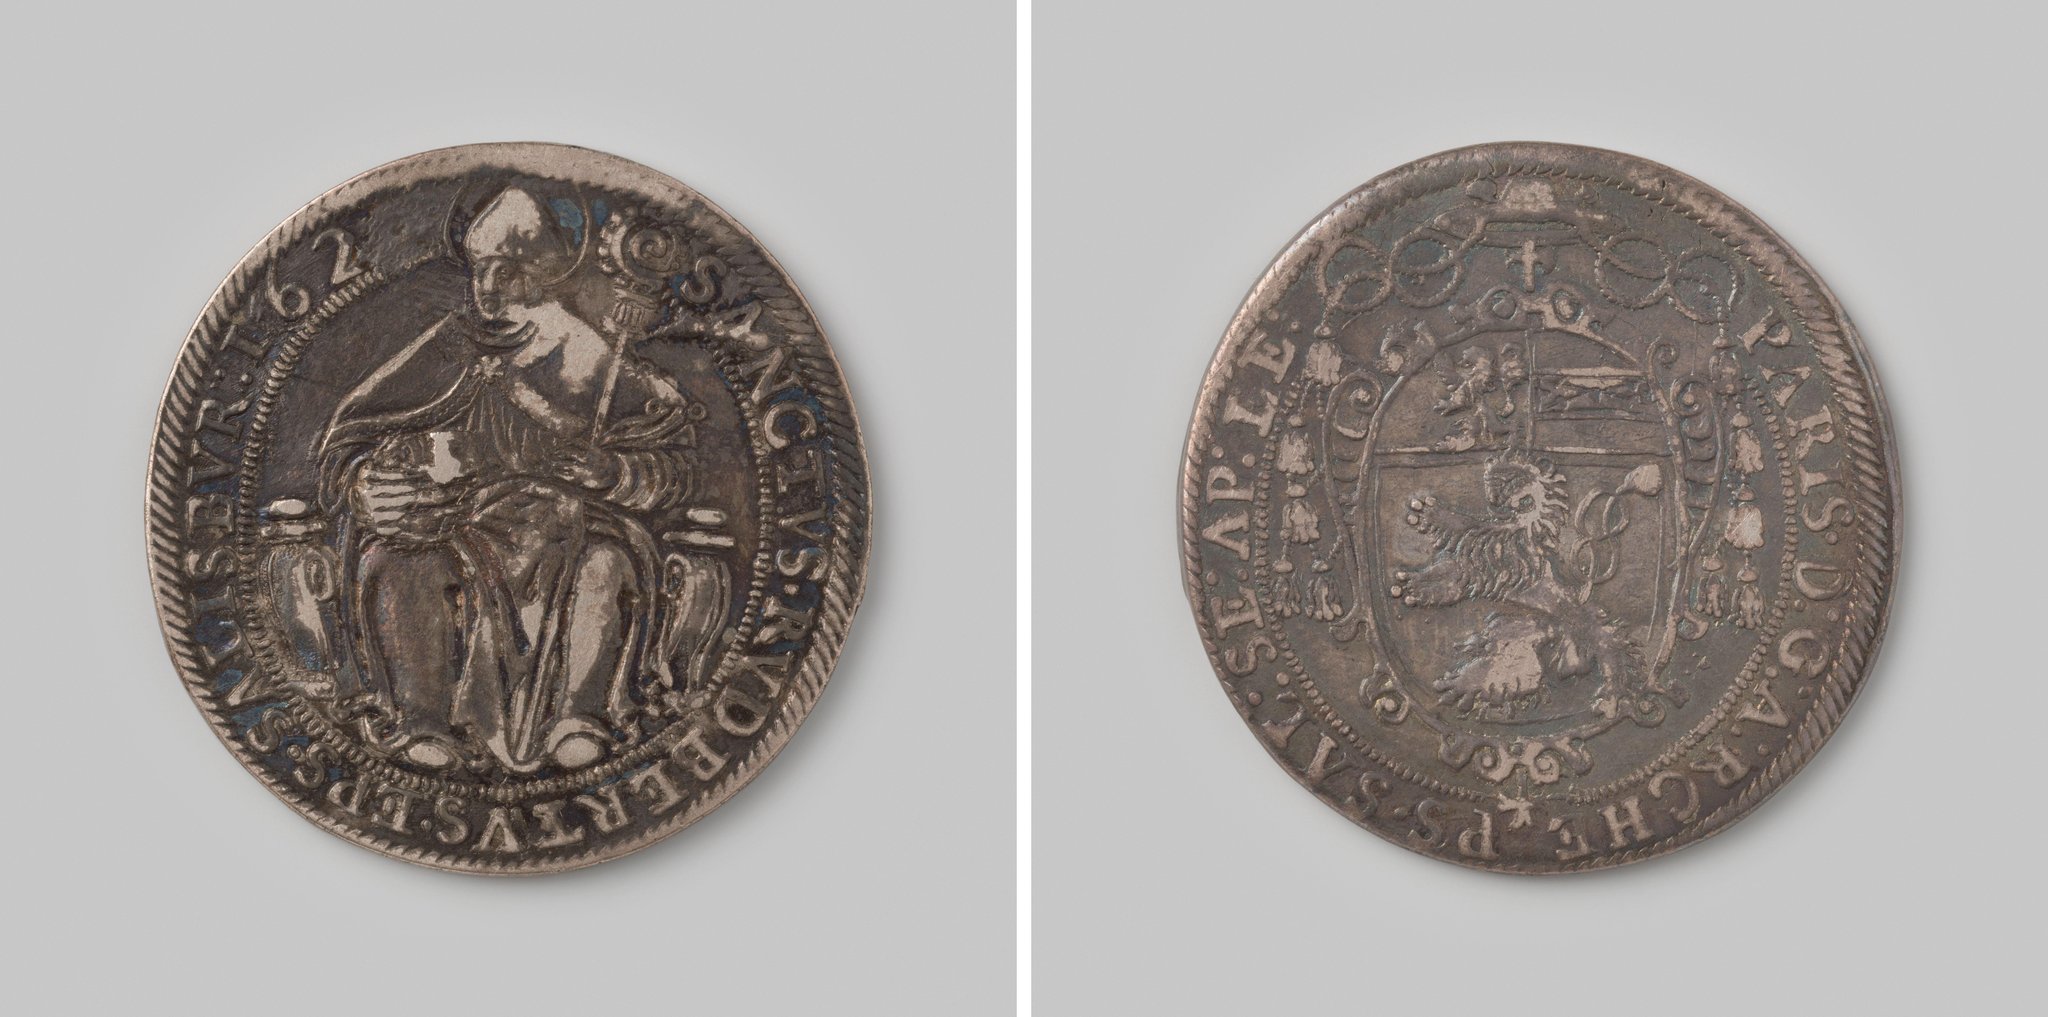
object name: taler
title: Taler uit het aartsbisdom Salzburg van Paris von Lodron,1620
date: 1620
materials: silver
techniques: striking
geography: salzburg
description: Zilveren munt. Voorzijde: versierd wapenschild, waarboven kruis met de hoed van de aarstbisschop. Keerzijde: zittende bisschop met mijter en staf. Jaartal (slecht leesbaar) aan het eind van het omschrift.